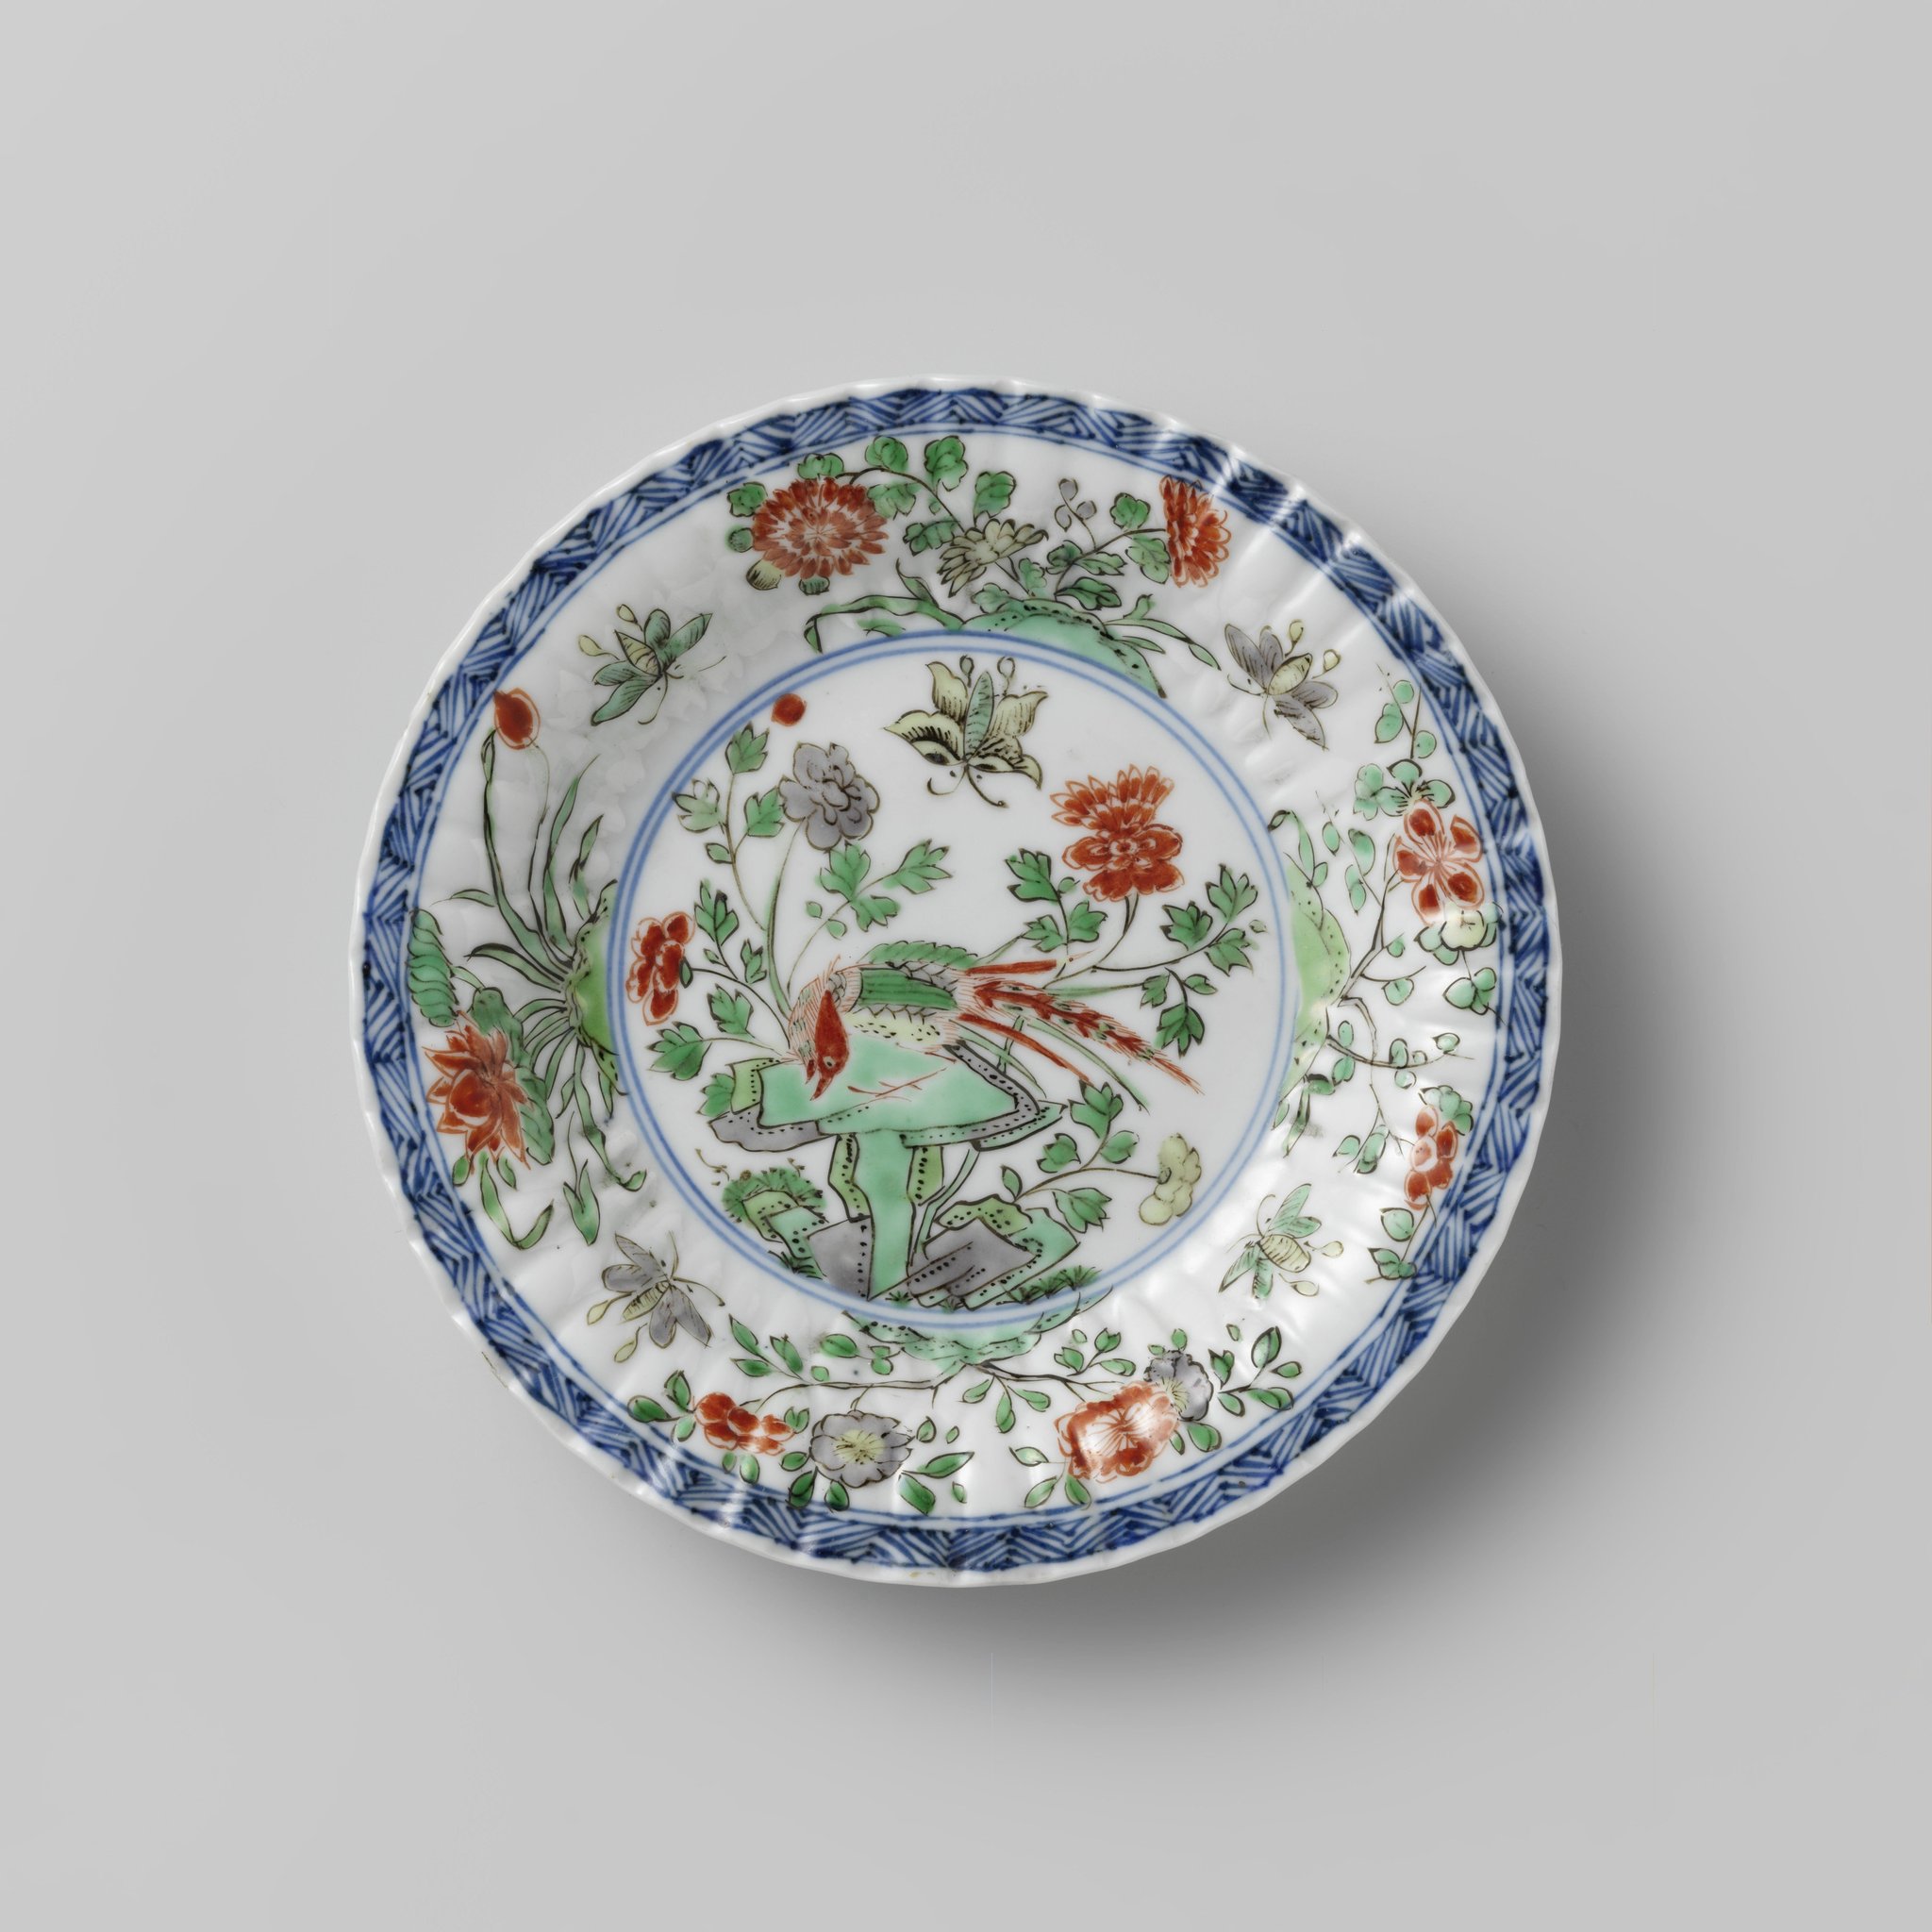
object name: platter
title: Saucer with rocks, flower sprays, pheasant and butterflies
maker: Anonymous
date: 1700-1724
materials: cobalt, glaze, paint, porcelain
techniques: firing, turning, vitrification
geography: china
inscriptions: mark